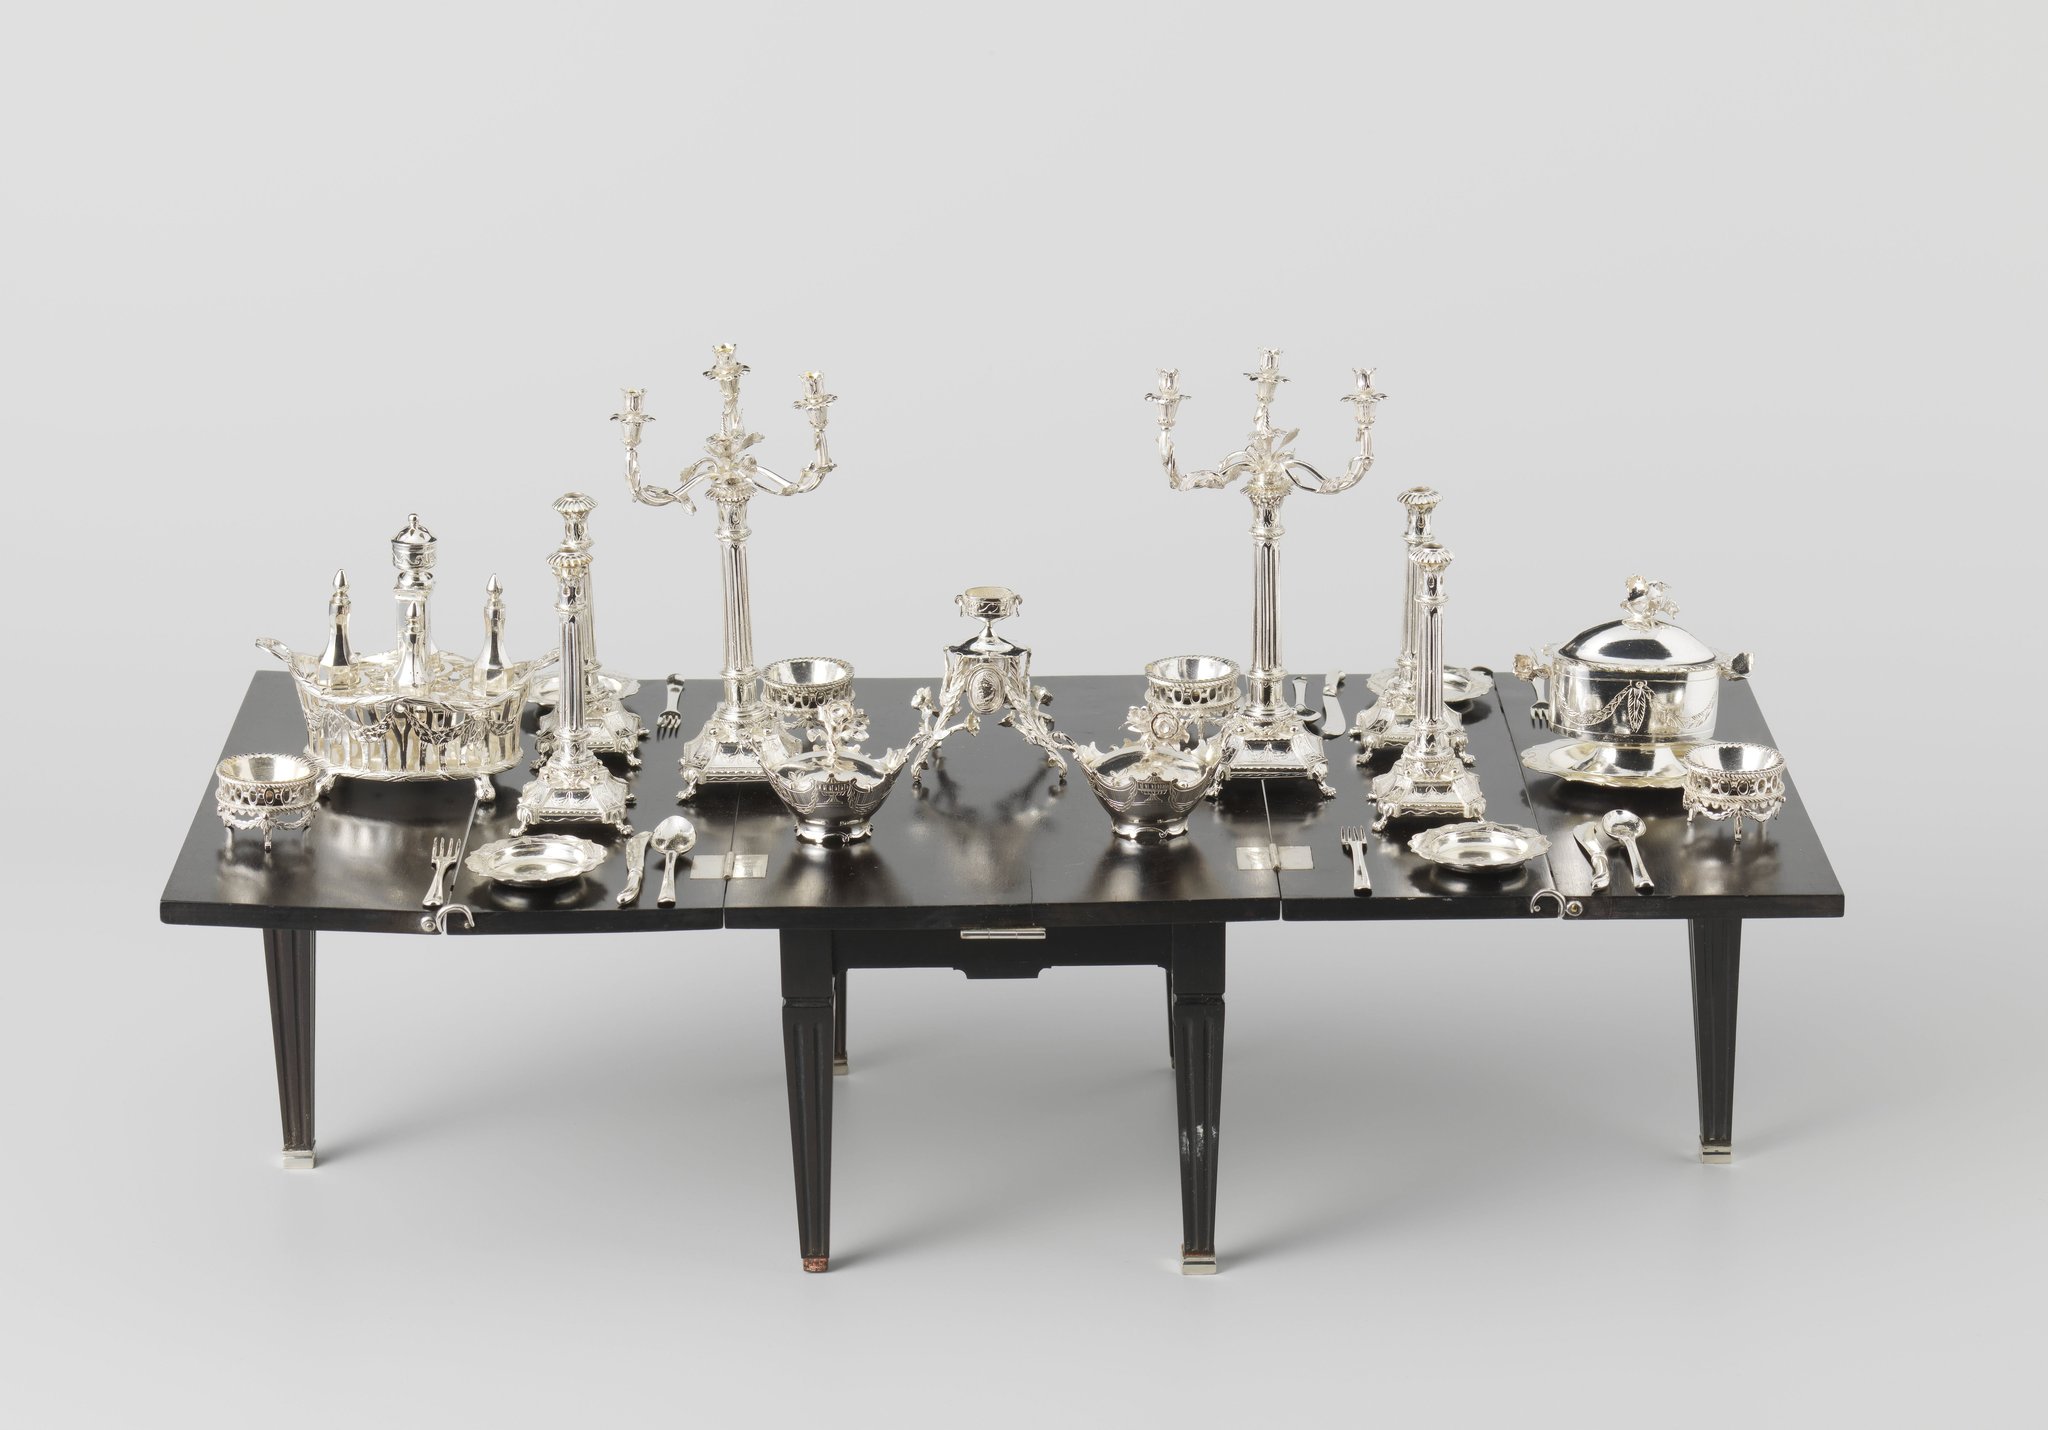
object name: miniature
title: Vork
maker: Anonymous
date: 1700-1800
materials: silver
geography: netherlands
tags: fork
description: Vork met vier tanden en een licht gebogen steel. De steel heeft een middenrichel en dubbel lof. De vork is gelijk aan drie vorken met invnrs. BK-NM-11177-225, BK-NM-11177-226 en BK-NM-11177-228. De vork is niet gemerkt.